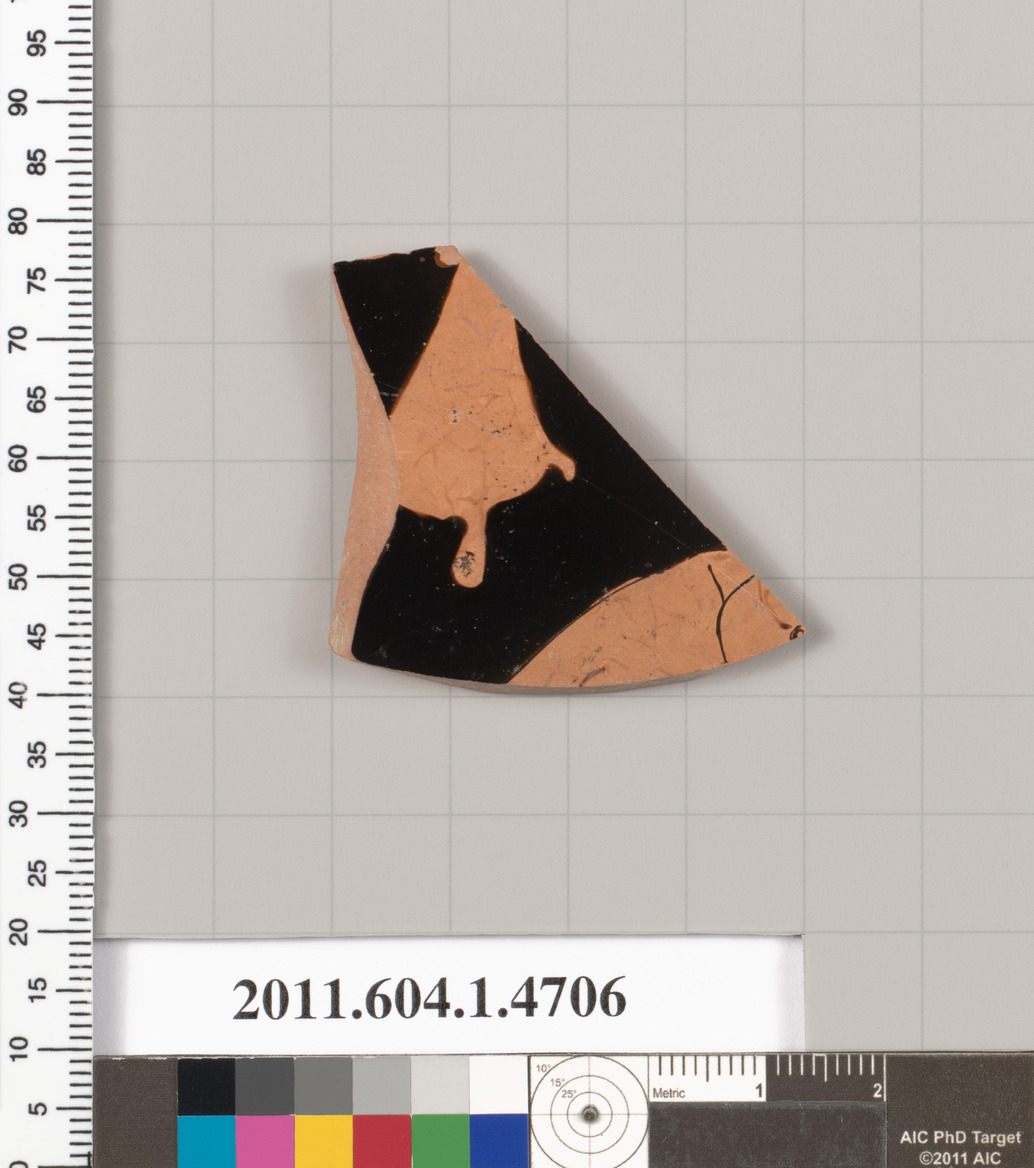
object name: kylix fragment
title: Terracotta fragment of a kylix (drinking cup)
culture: greek, attic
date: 475-451 BCE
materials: terracotta